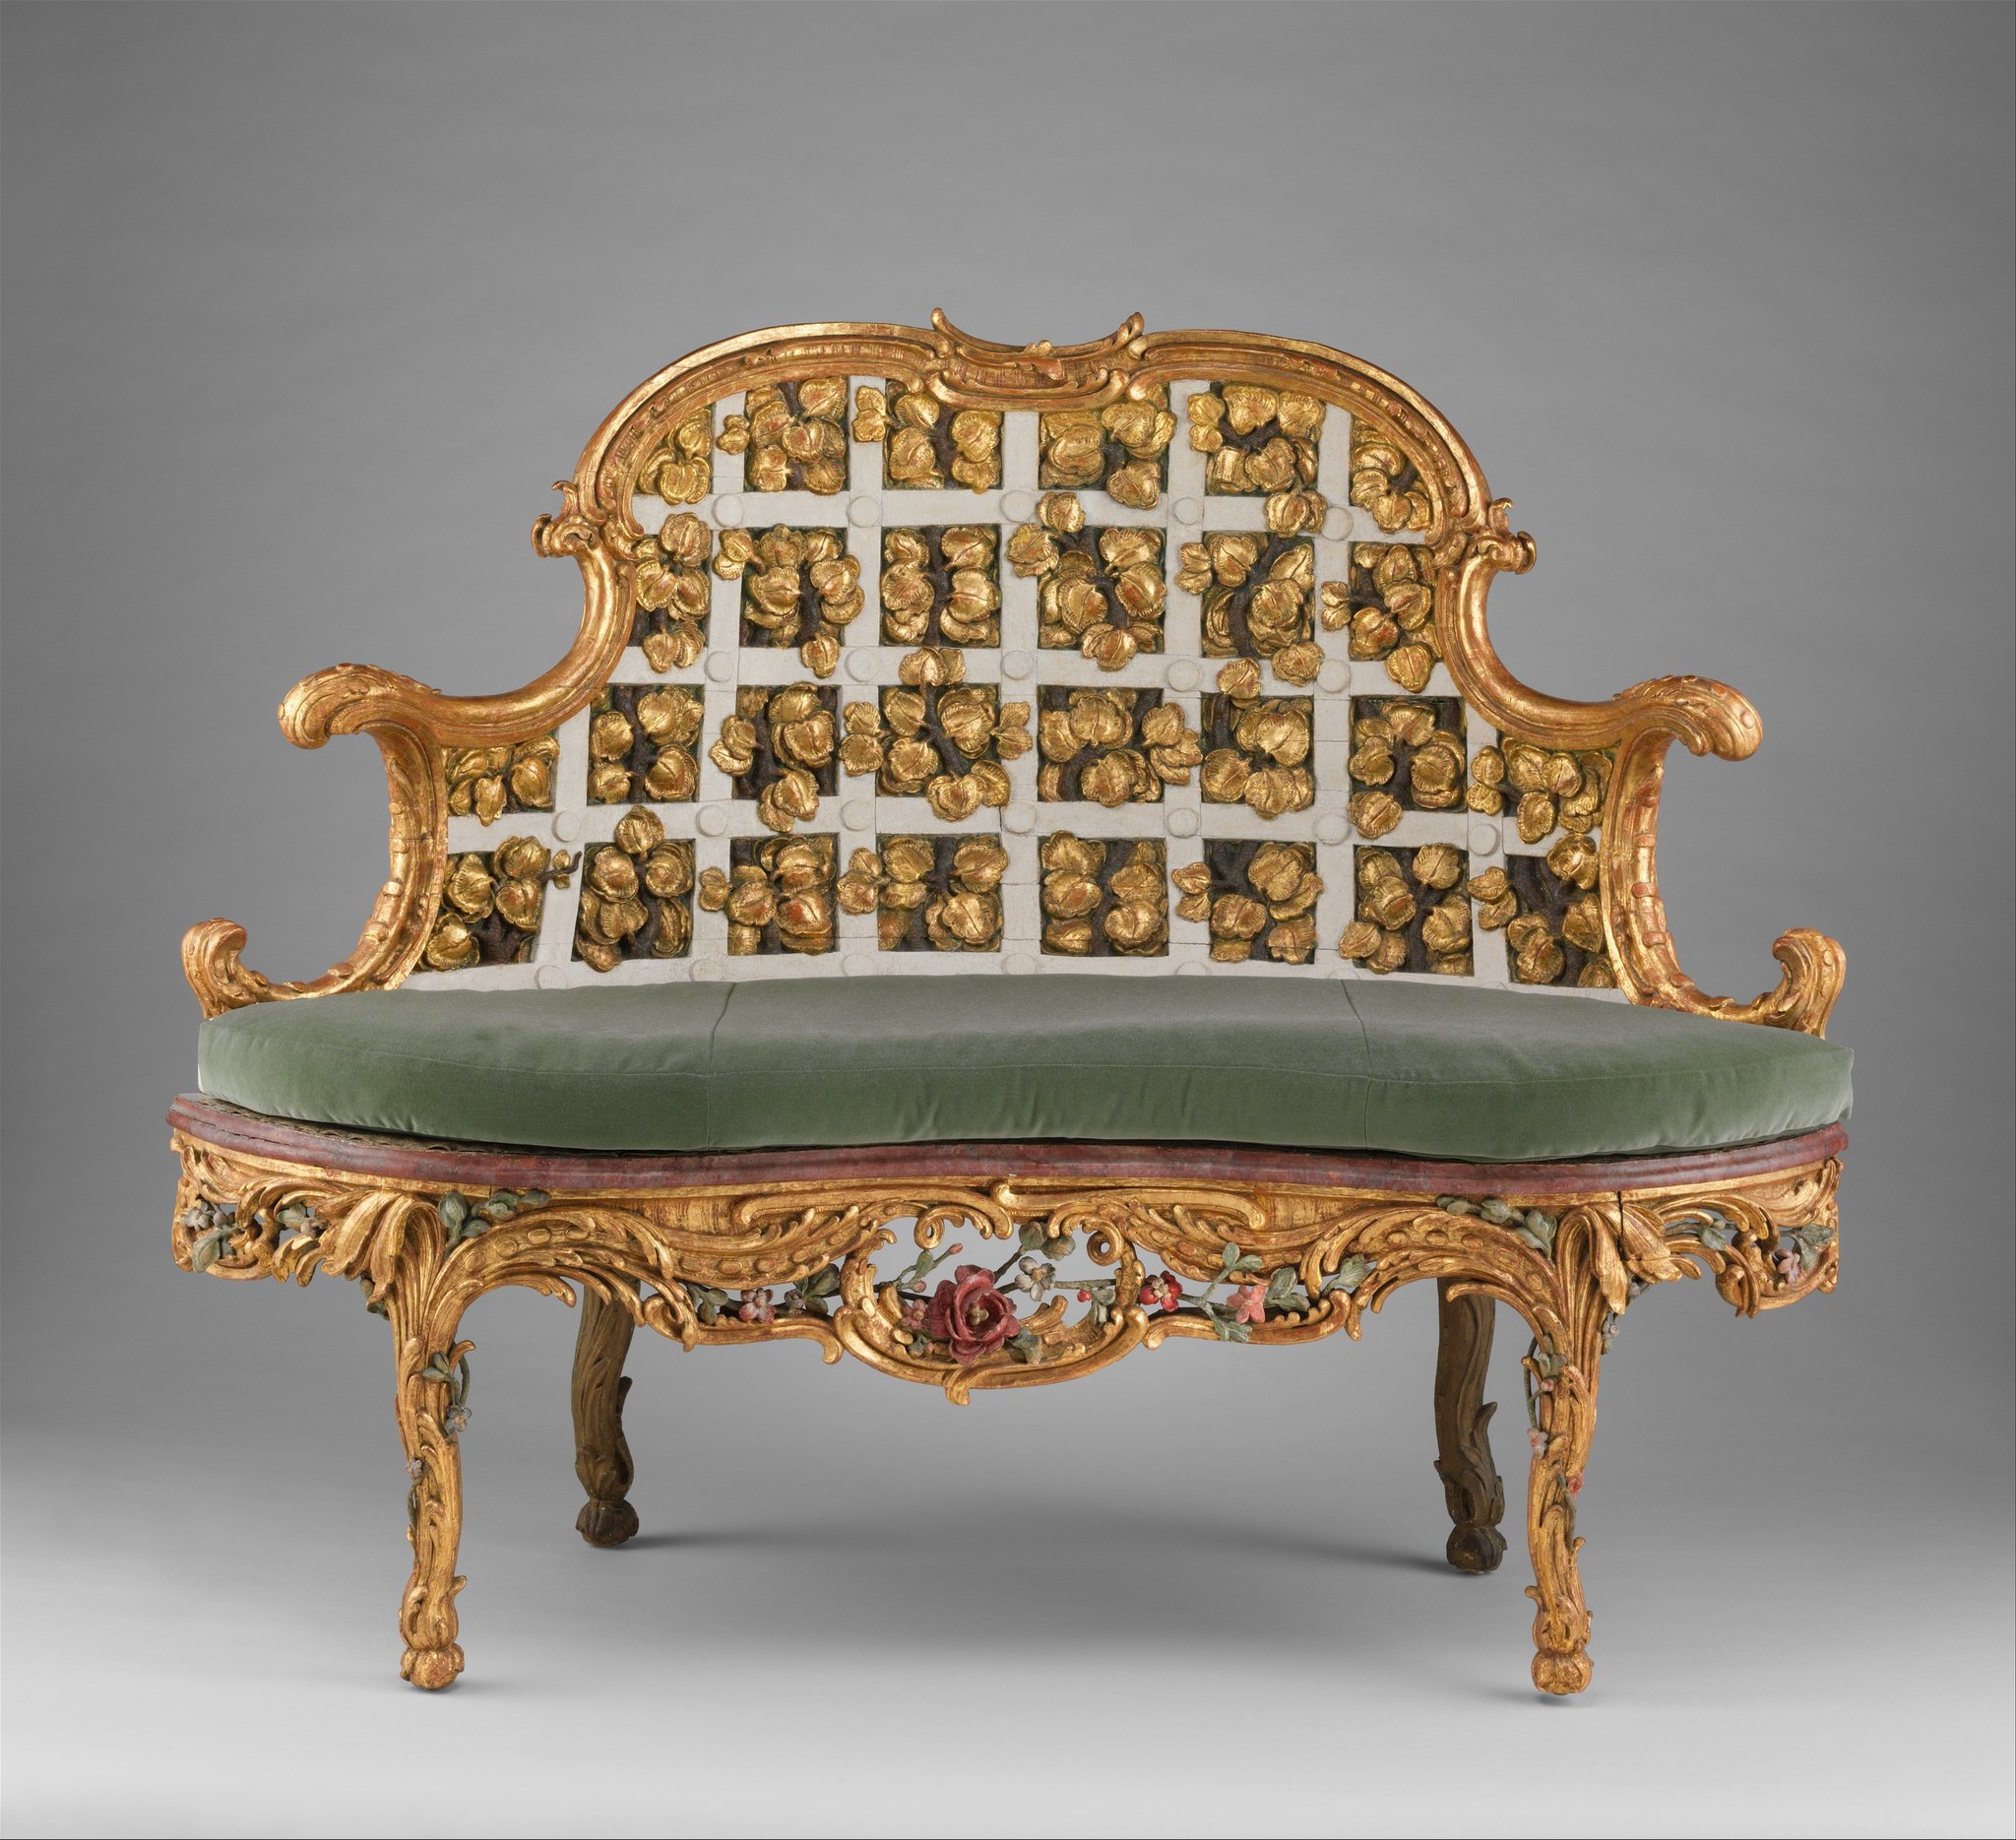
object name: settee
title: Settee (one of a pair) (part of a set)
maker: johann michael bauer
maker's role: maker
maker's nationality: german, born westheim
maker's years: 1710-1779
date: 1763-1764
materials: wood, silk, velvet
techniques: carving, gilding, painting